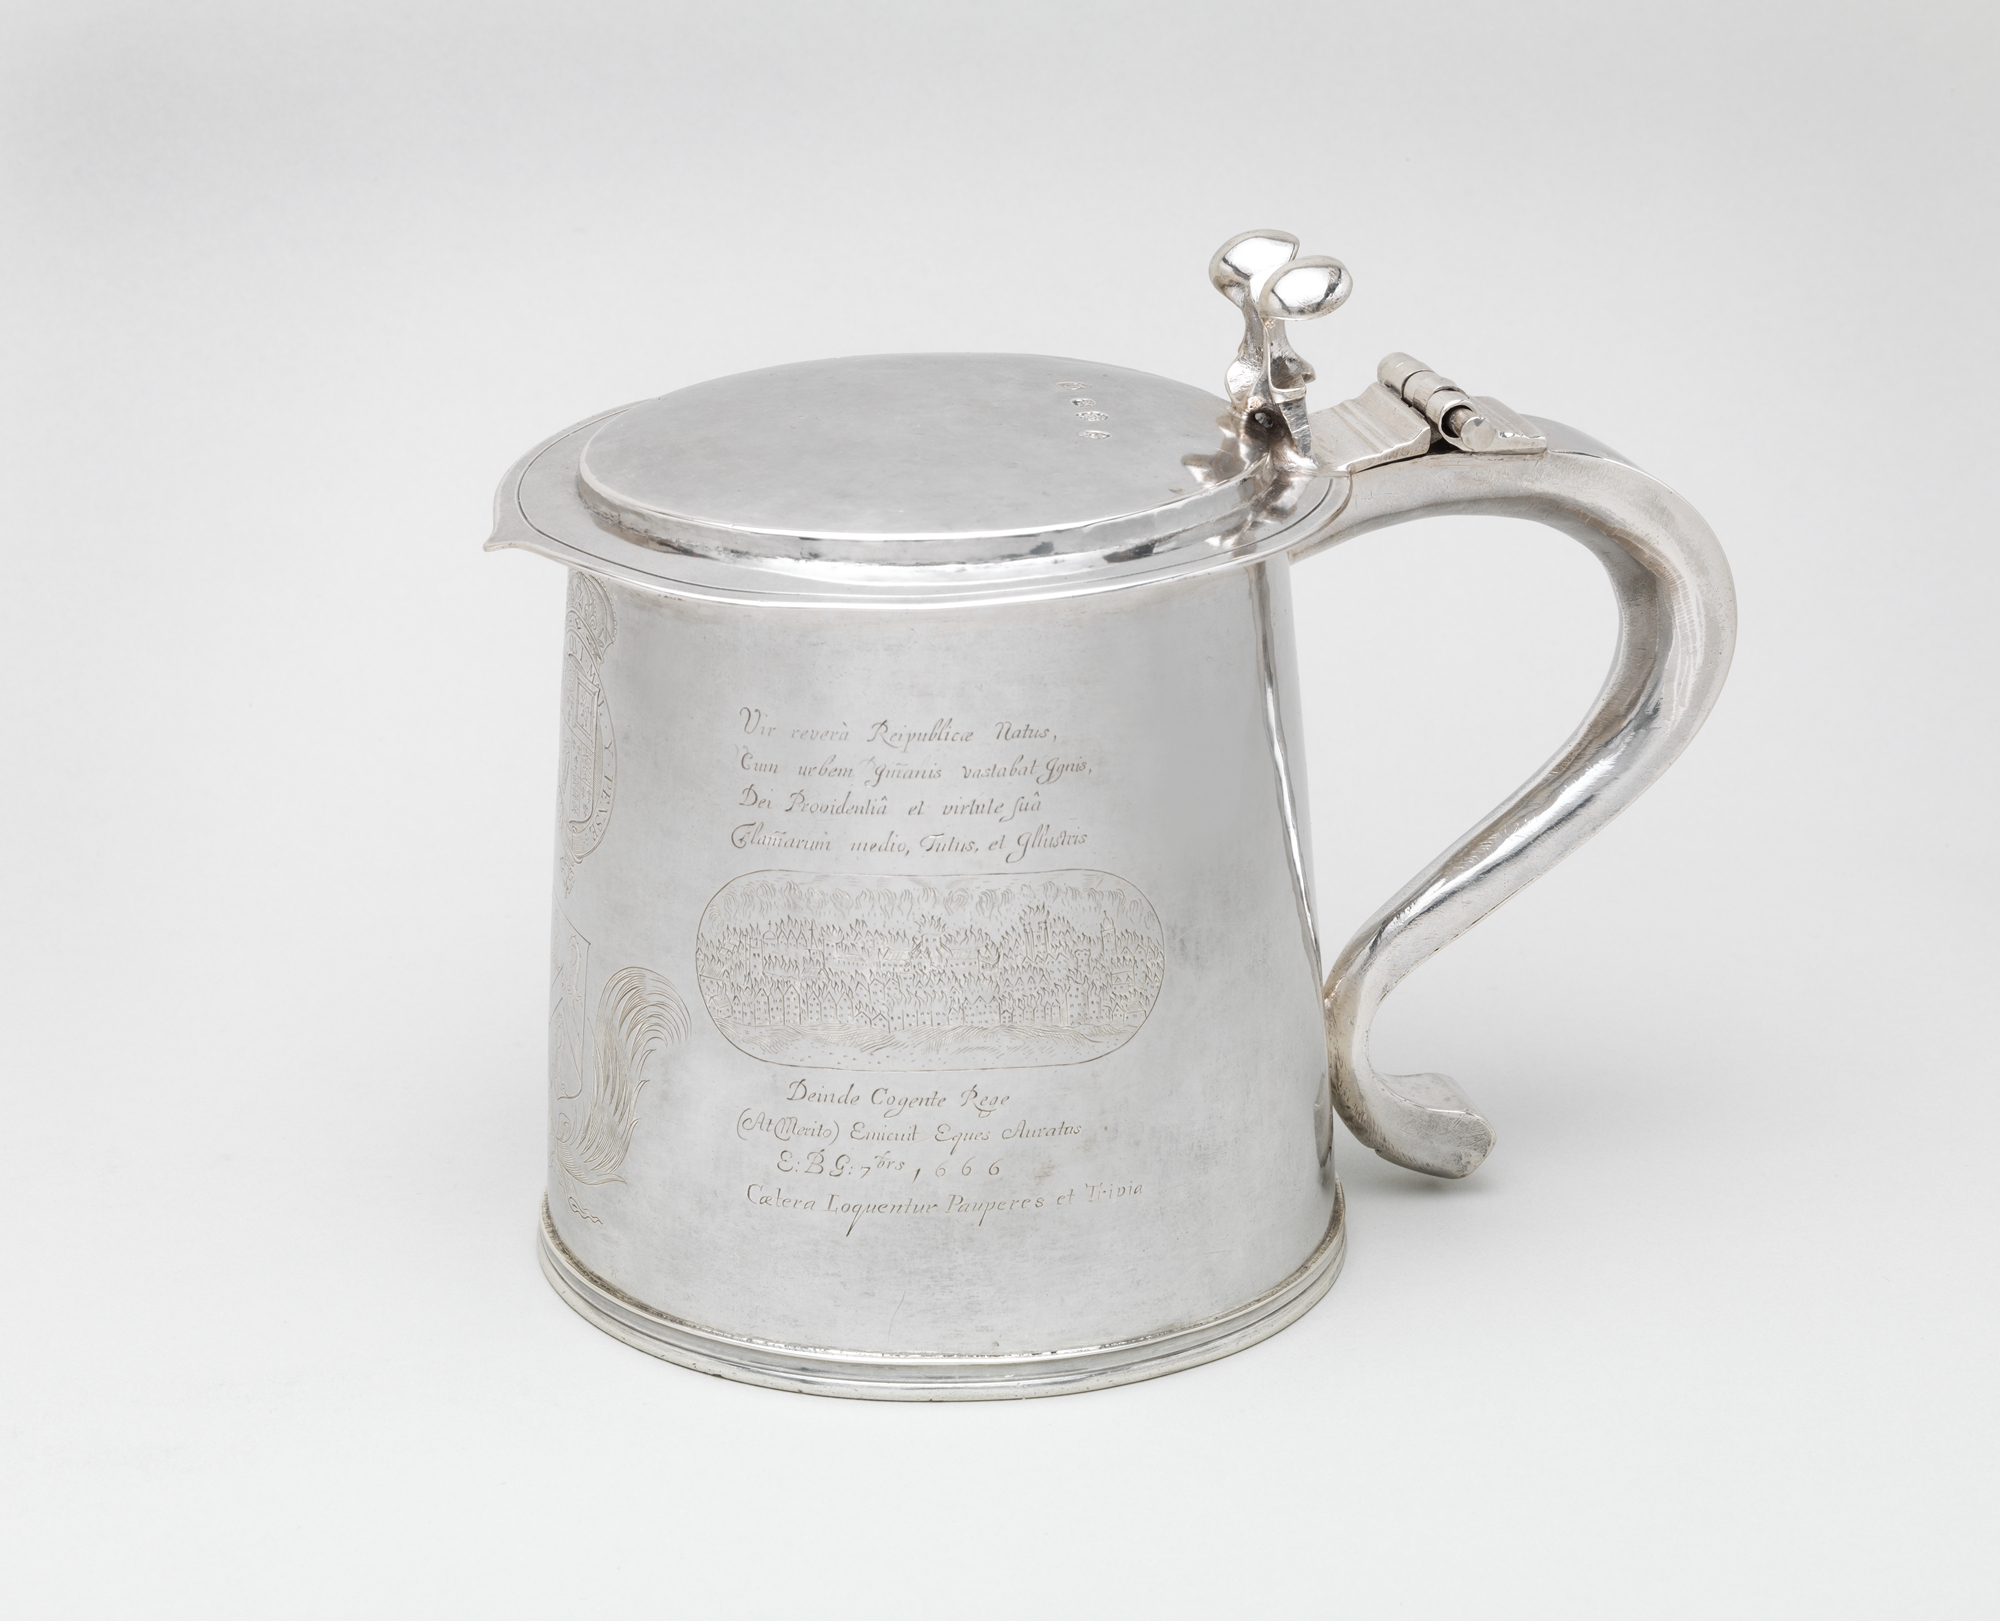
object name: tankard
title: Tankard engraved with scenes of the Great Plague and the Great Fire of London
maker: o s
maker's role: maker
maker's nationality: british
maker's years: 1673-1677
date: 1673-1674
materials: silver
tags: cities,fire,coat of arms